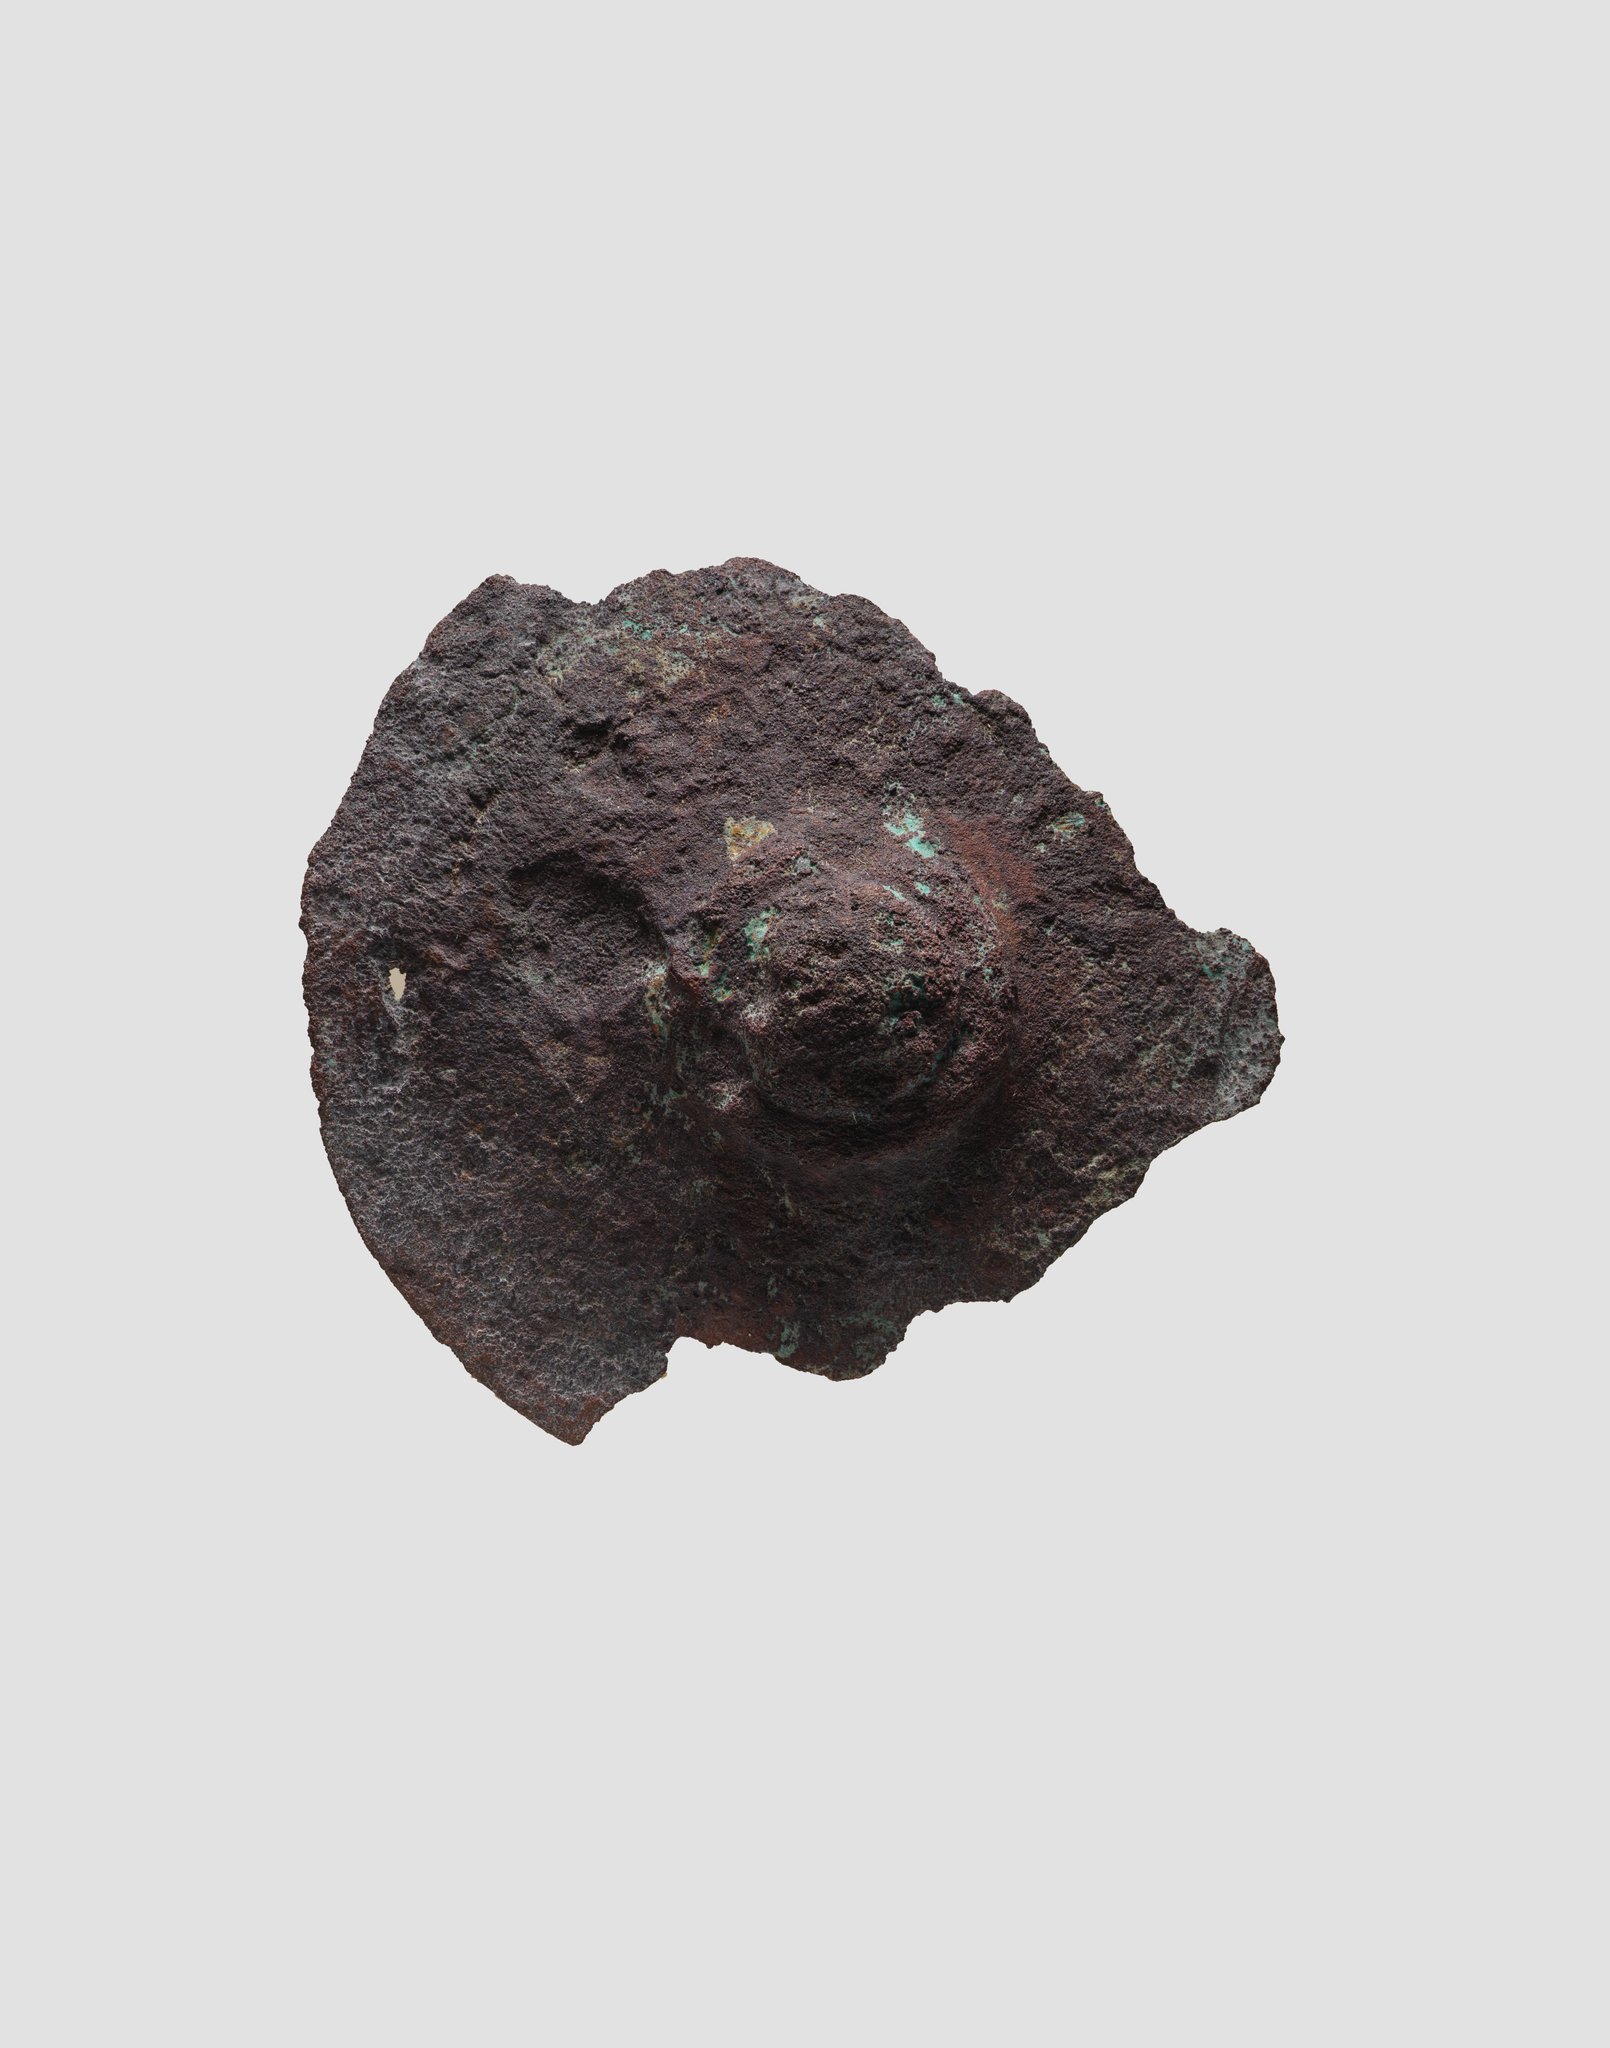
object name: bos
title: Boss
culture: iranian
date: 900-801 BCE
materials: bronze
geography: iran